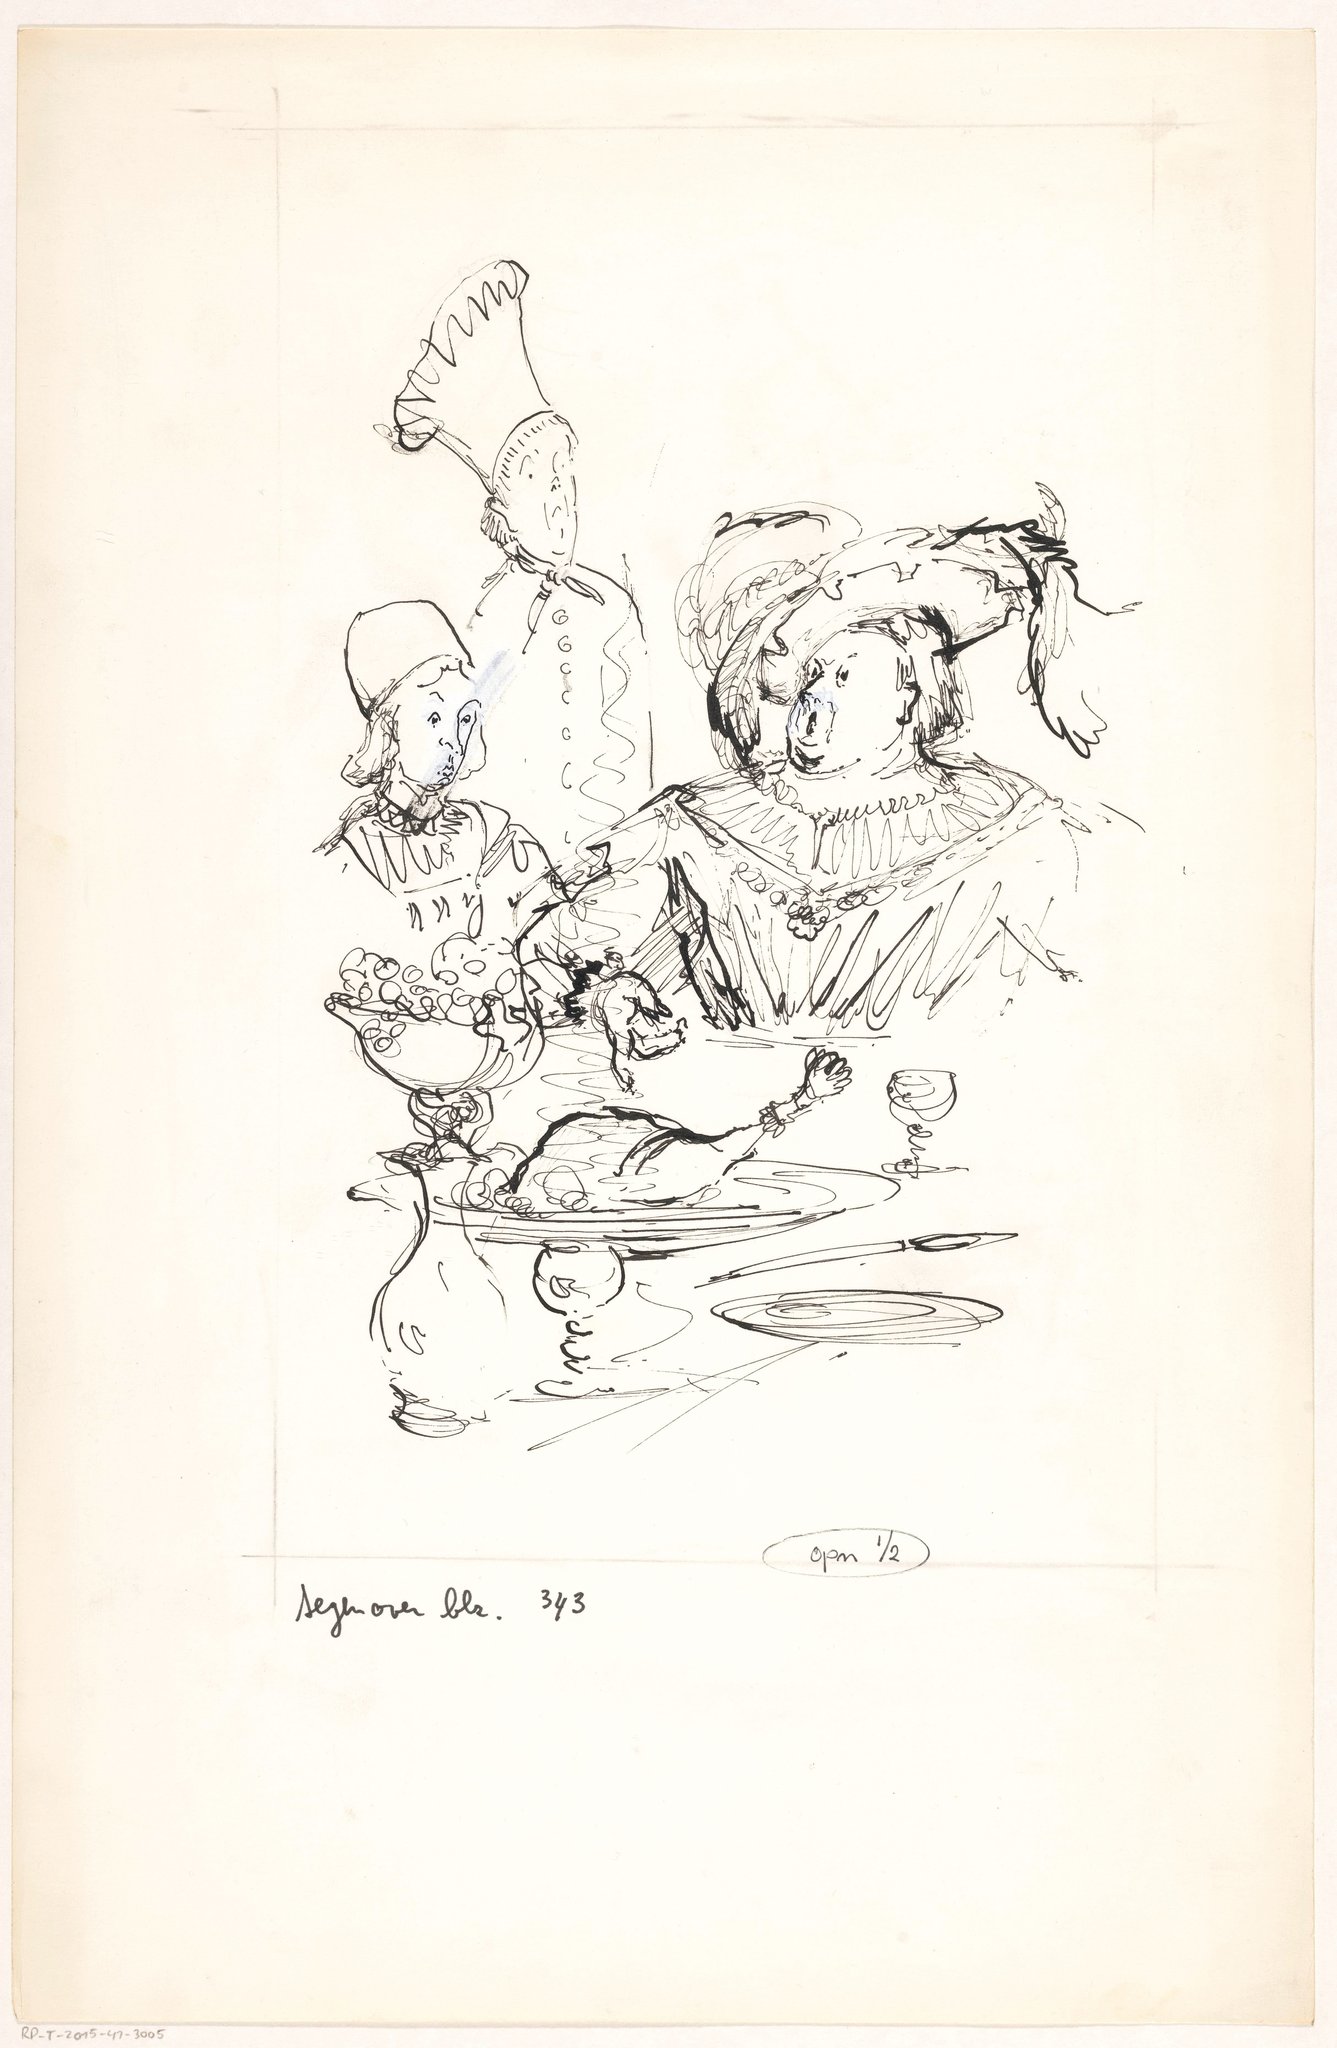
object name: boekillustratie ontwerp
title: Man wijst naar een bout vlees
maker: Anonymous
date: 1900-1970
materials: paint, ink, paper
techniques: brush, pen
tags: historical costume (+ men's clothes), cook, celebration meal, feast, banquet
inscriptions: collector's mark: Lugt 2228a, :, annotation: ‘tegenover blz. 343’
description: Een man gekleed in historisch kostuum en een hoed met veren zit aan een gedekte tafel. Op tafel staan etenswaren, waaronder een schaal met een bout vlees. De man wijst naar het vlees. Naast hem staan een bediende en kok.